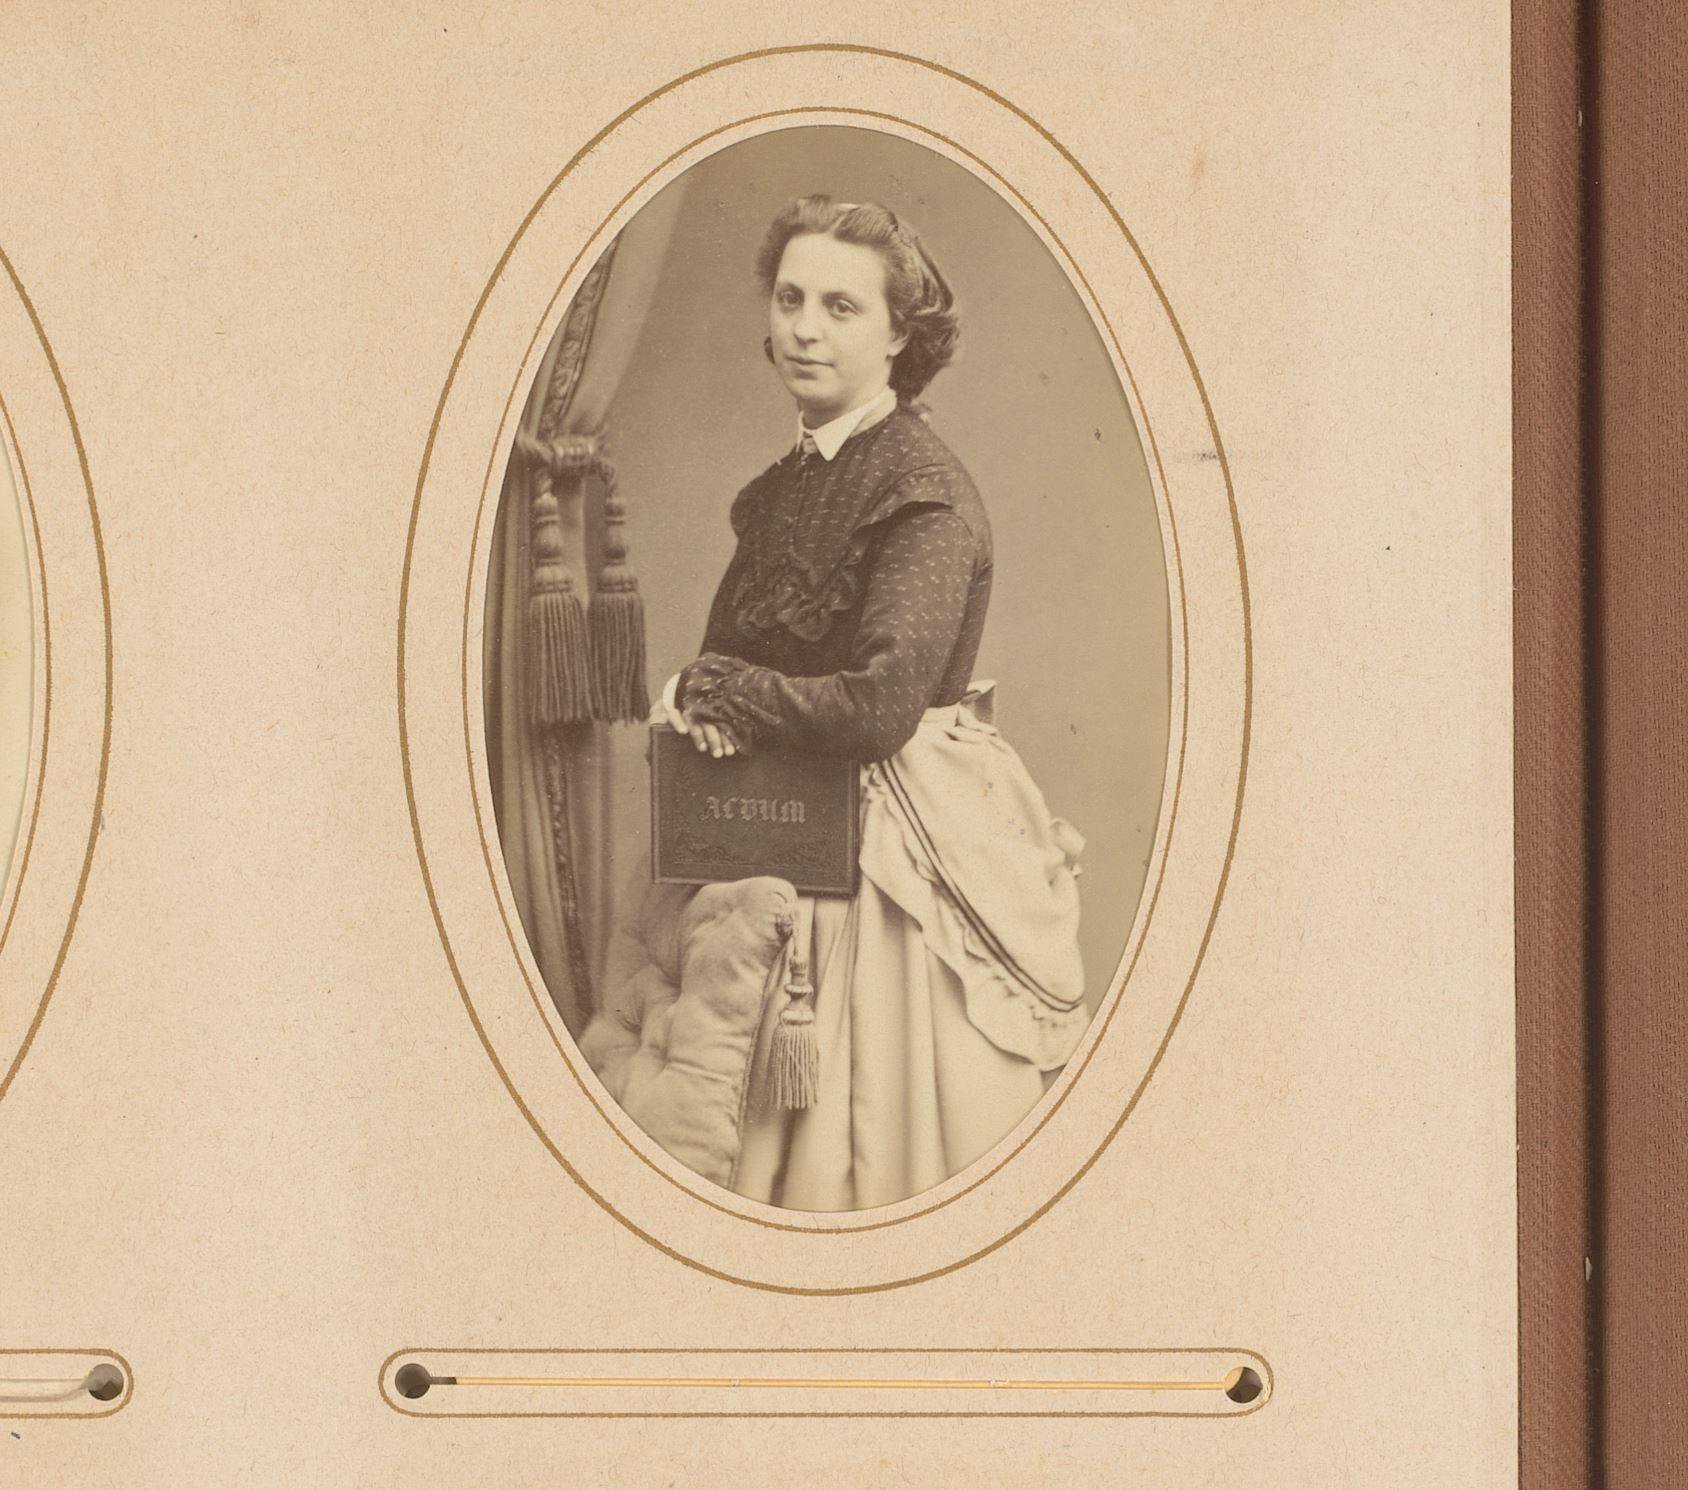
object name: album leaf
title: Portret van een staande vrouw met fotoalbum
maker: albert greiner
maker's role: fotograaf, fotostudio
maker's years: 1833-1890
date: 1861-1874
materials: cardboard, photographic support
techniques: albumen print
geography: amsterdam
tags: historical persons - bb - woman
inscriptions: inscription: ‘A. Greiner/ Photograf/ Nieuwendijk L.87/ Amsterdam’